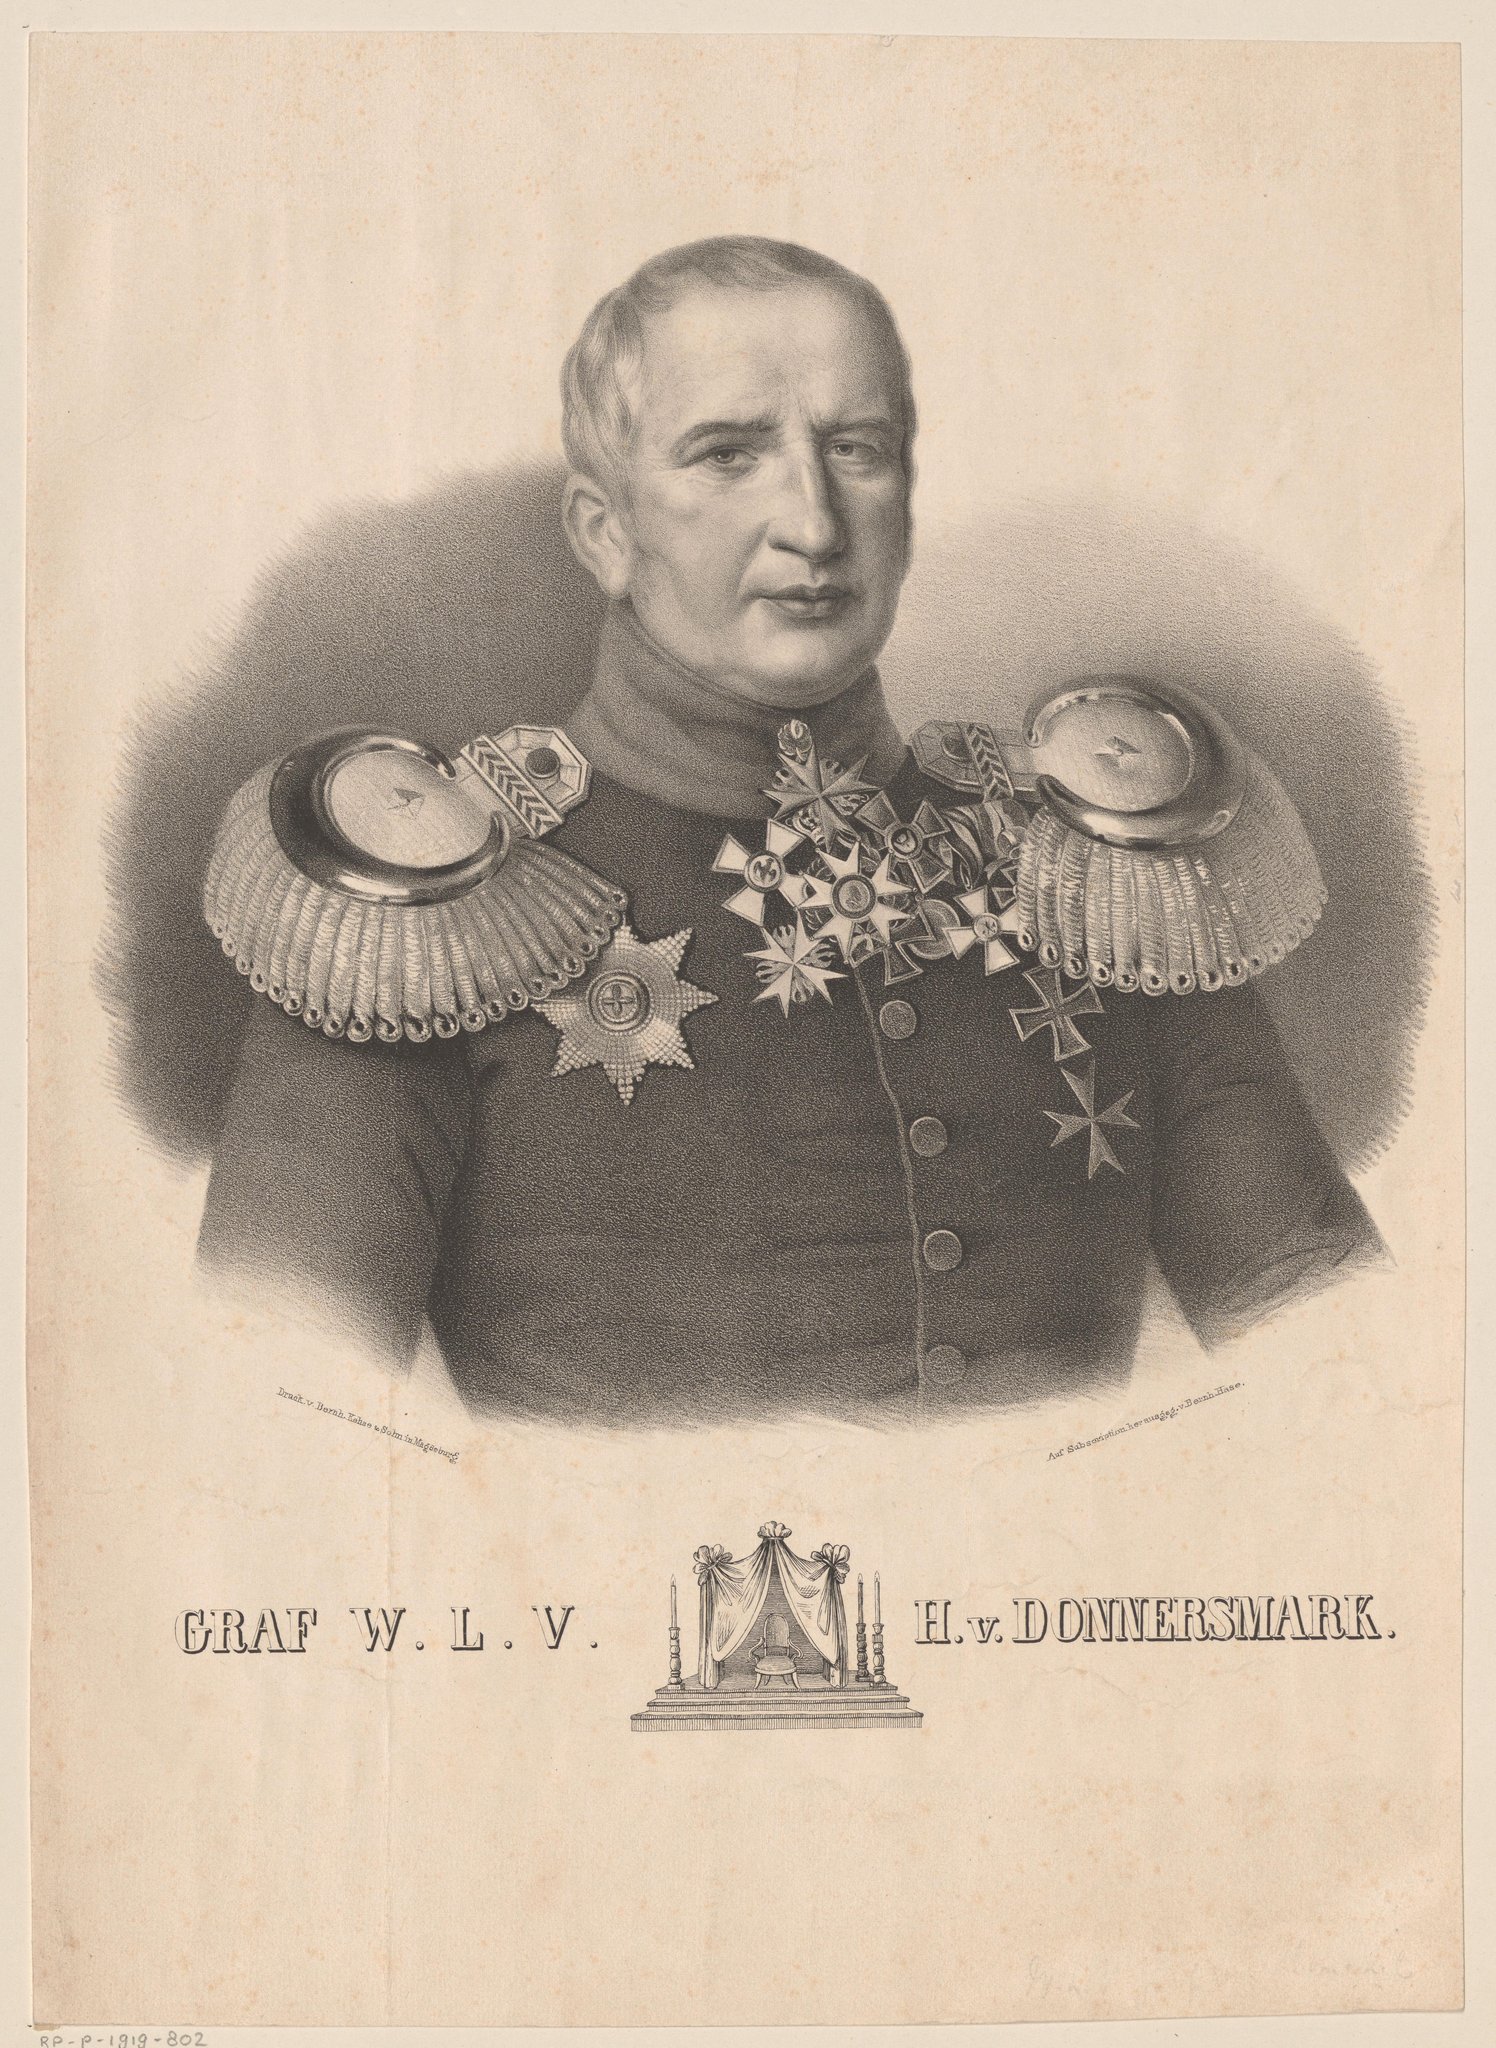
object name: print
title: Portret van Wilhelm Ludwig Viktor Henckel von Donnersmarck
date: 1830-1840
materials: paper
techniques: lithograph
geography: magdeburg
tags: historical persons, officer, medals and other marks of military honour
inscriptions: collector's mark: Lugt 2228